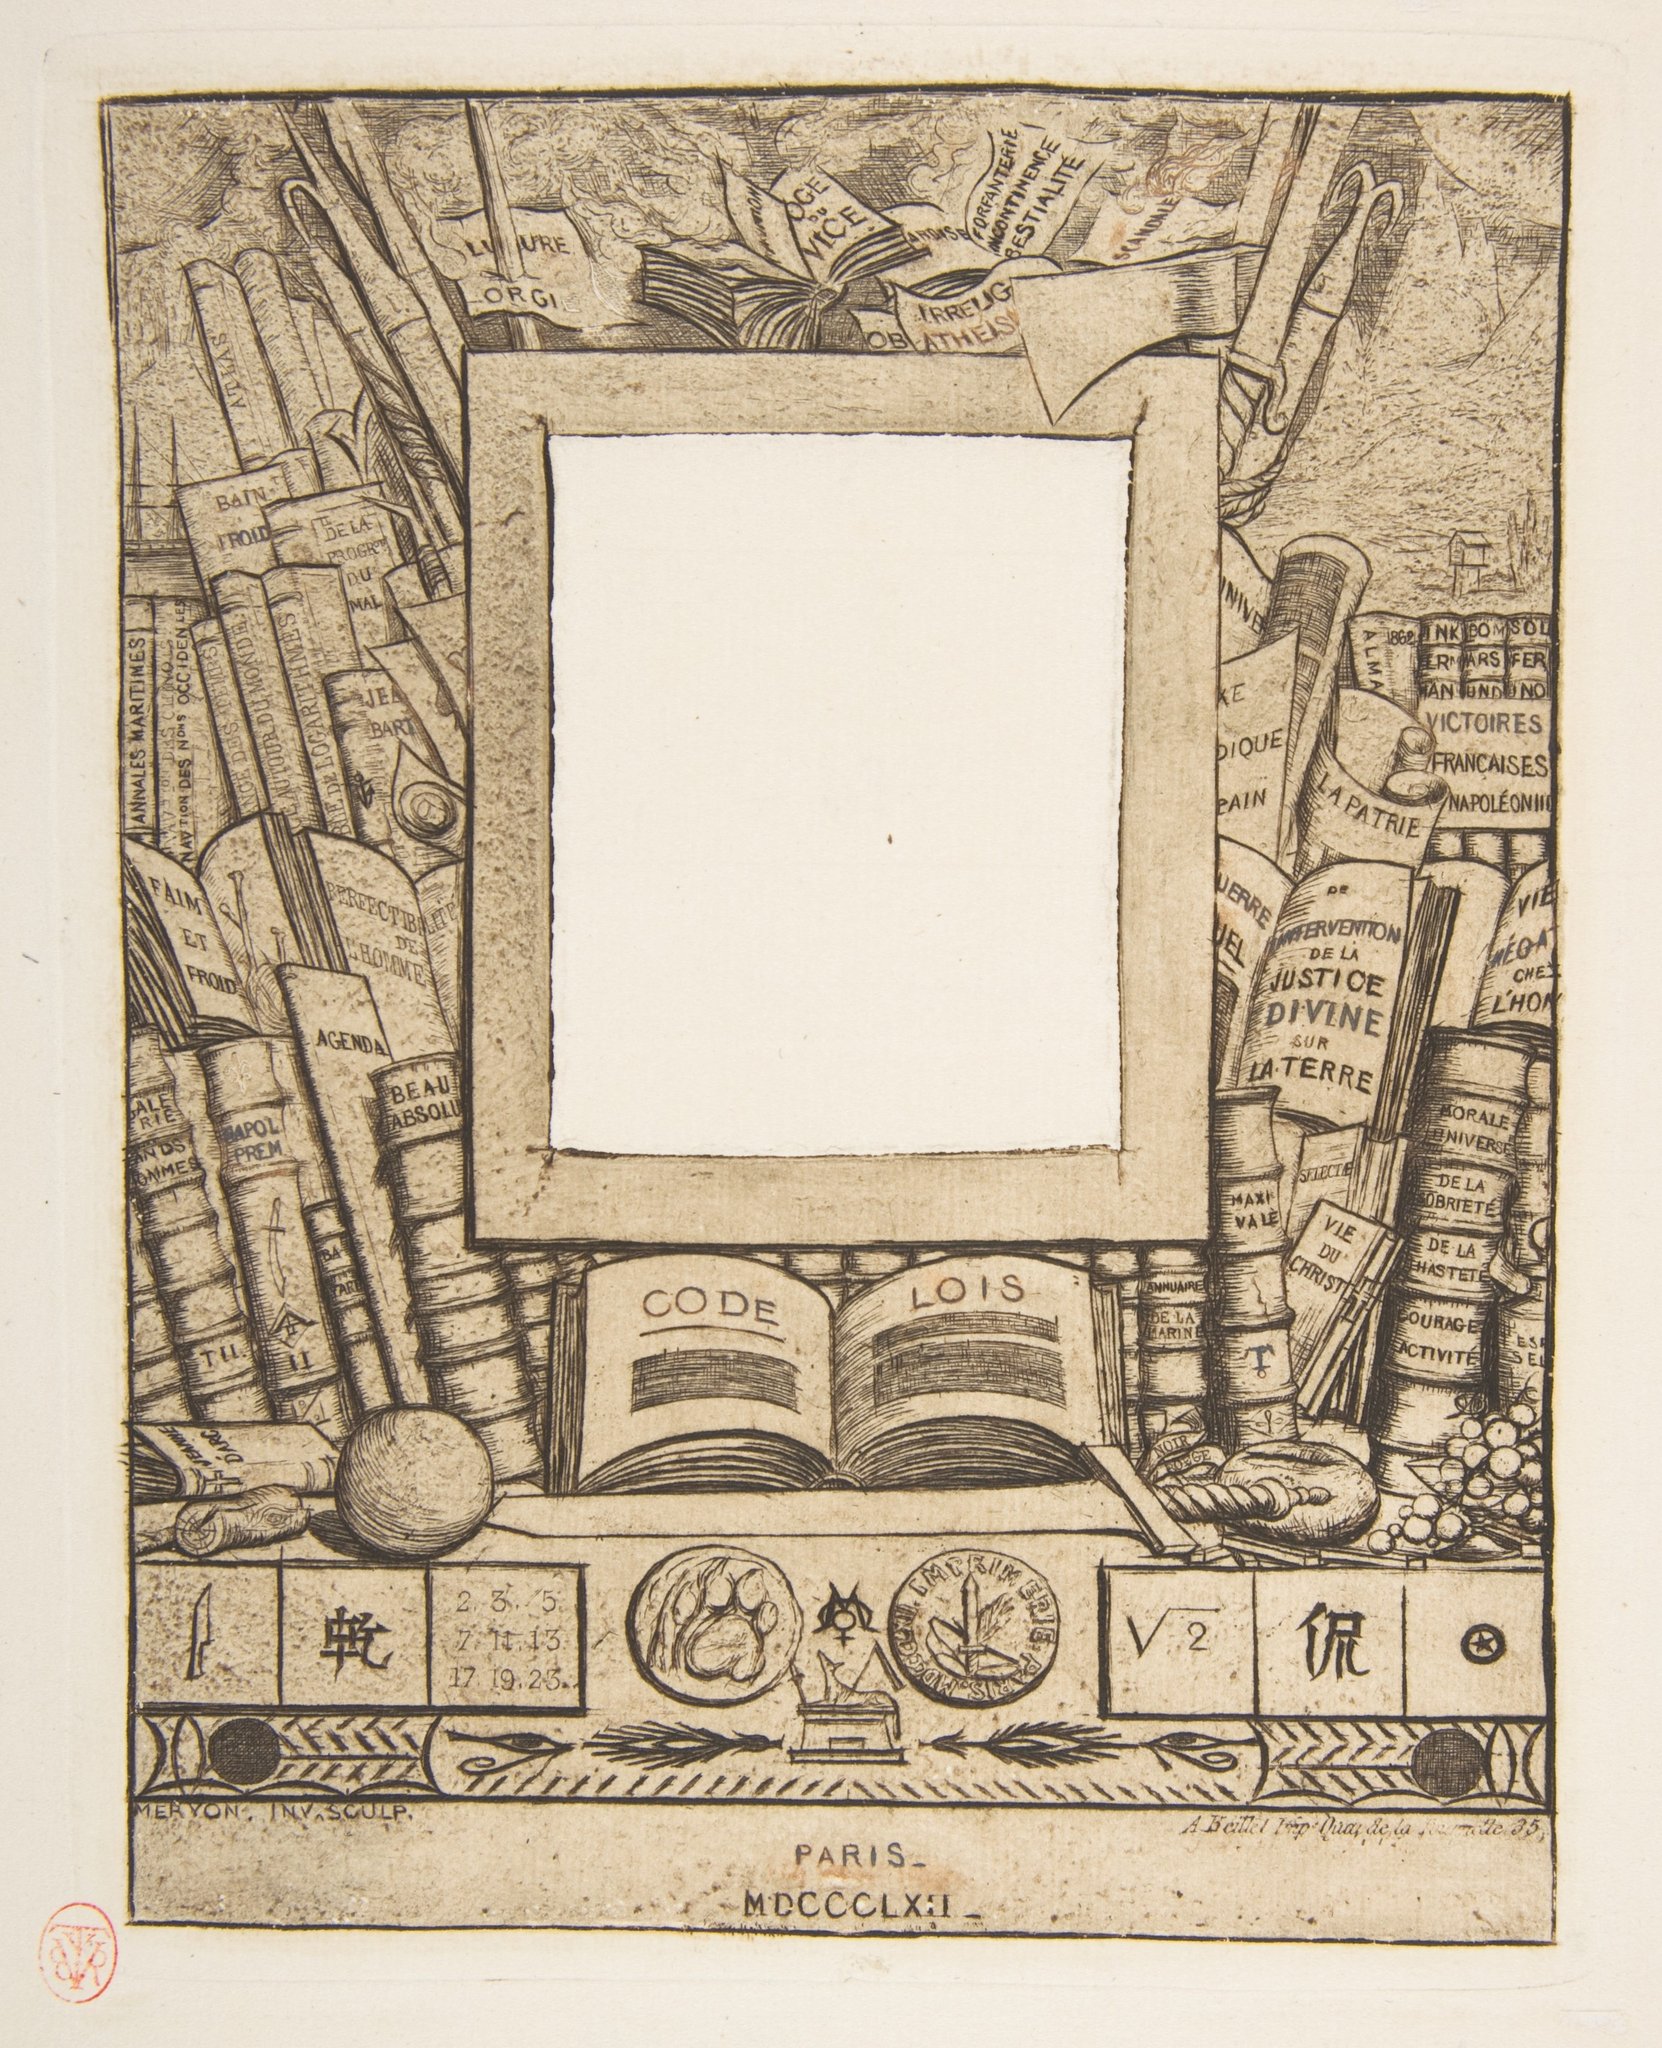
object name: print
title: Design for a frame for the portrait of Armand Guéraud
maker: charles meryon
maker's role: artist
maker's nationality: french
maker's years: 1821-1868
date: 1862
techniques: drypoint, etching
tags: books